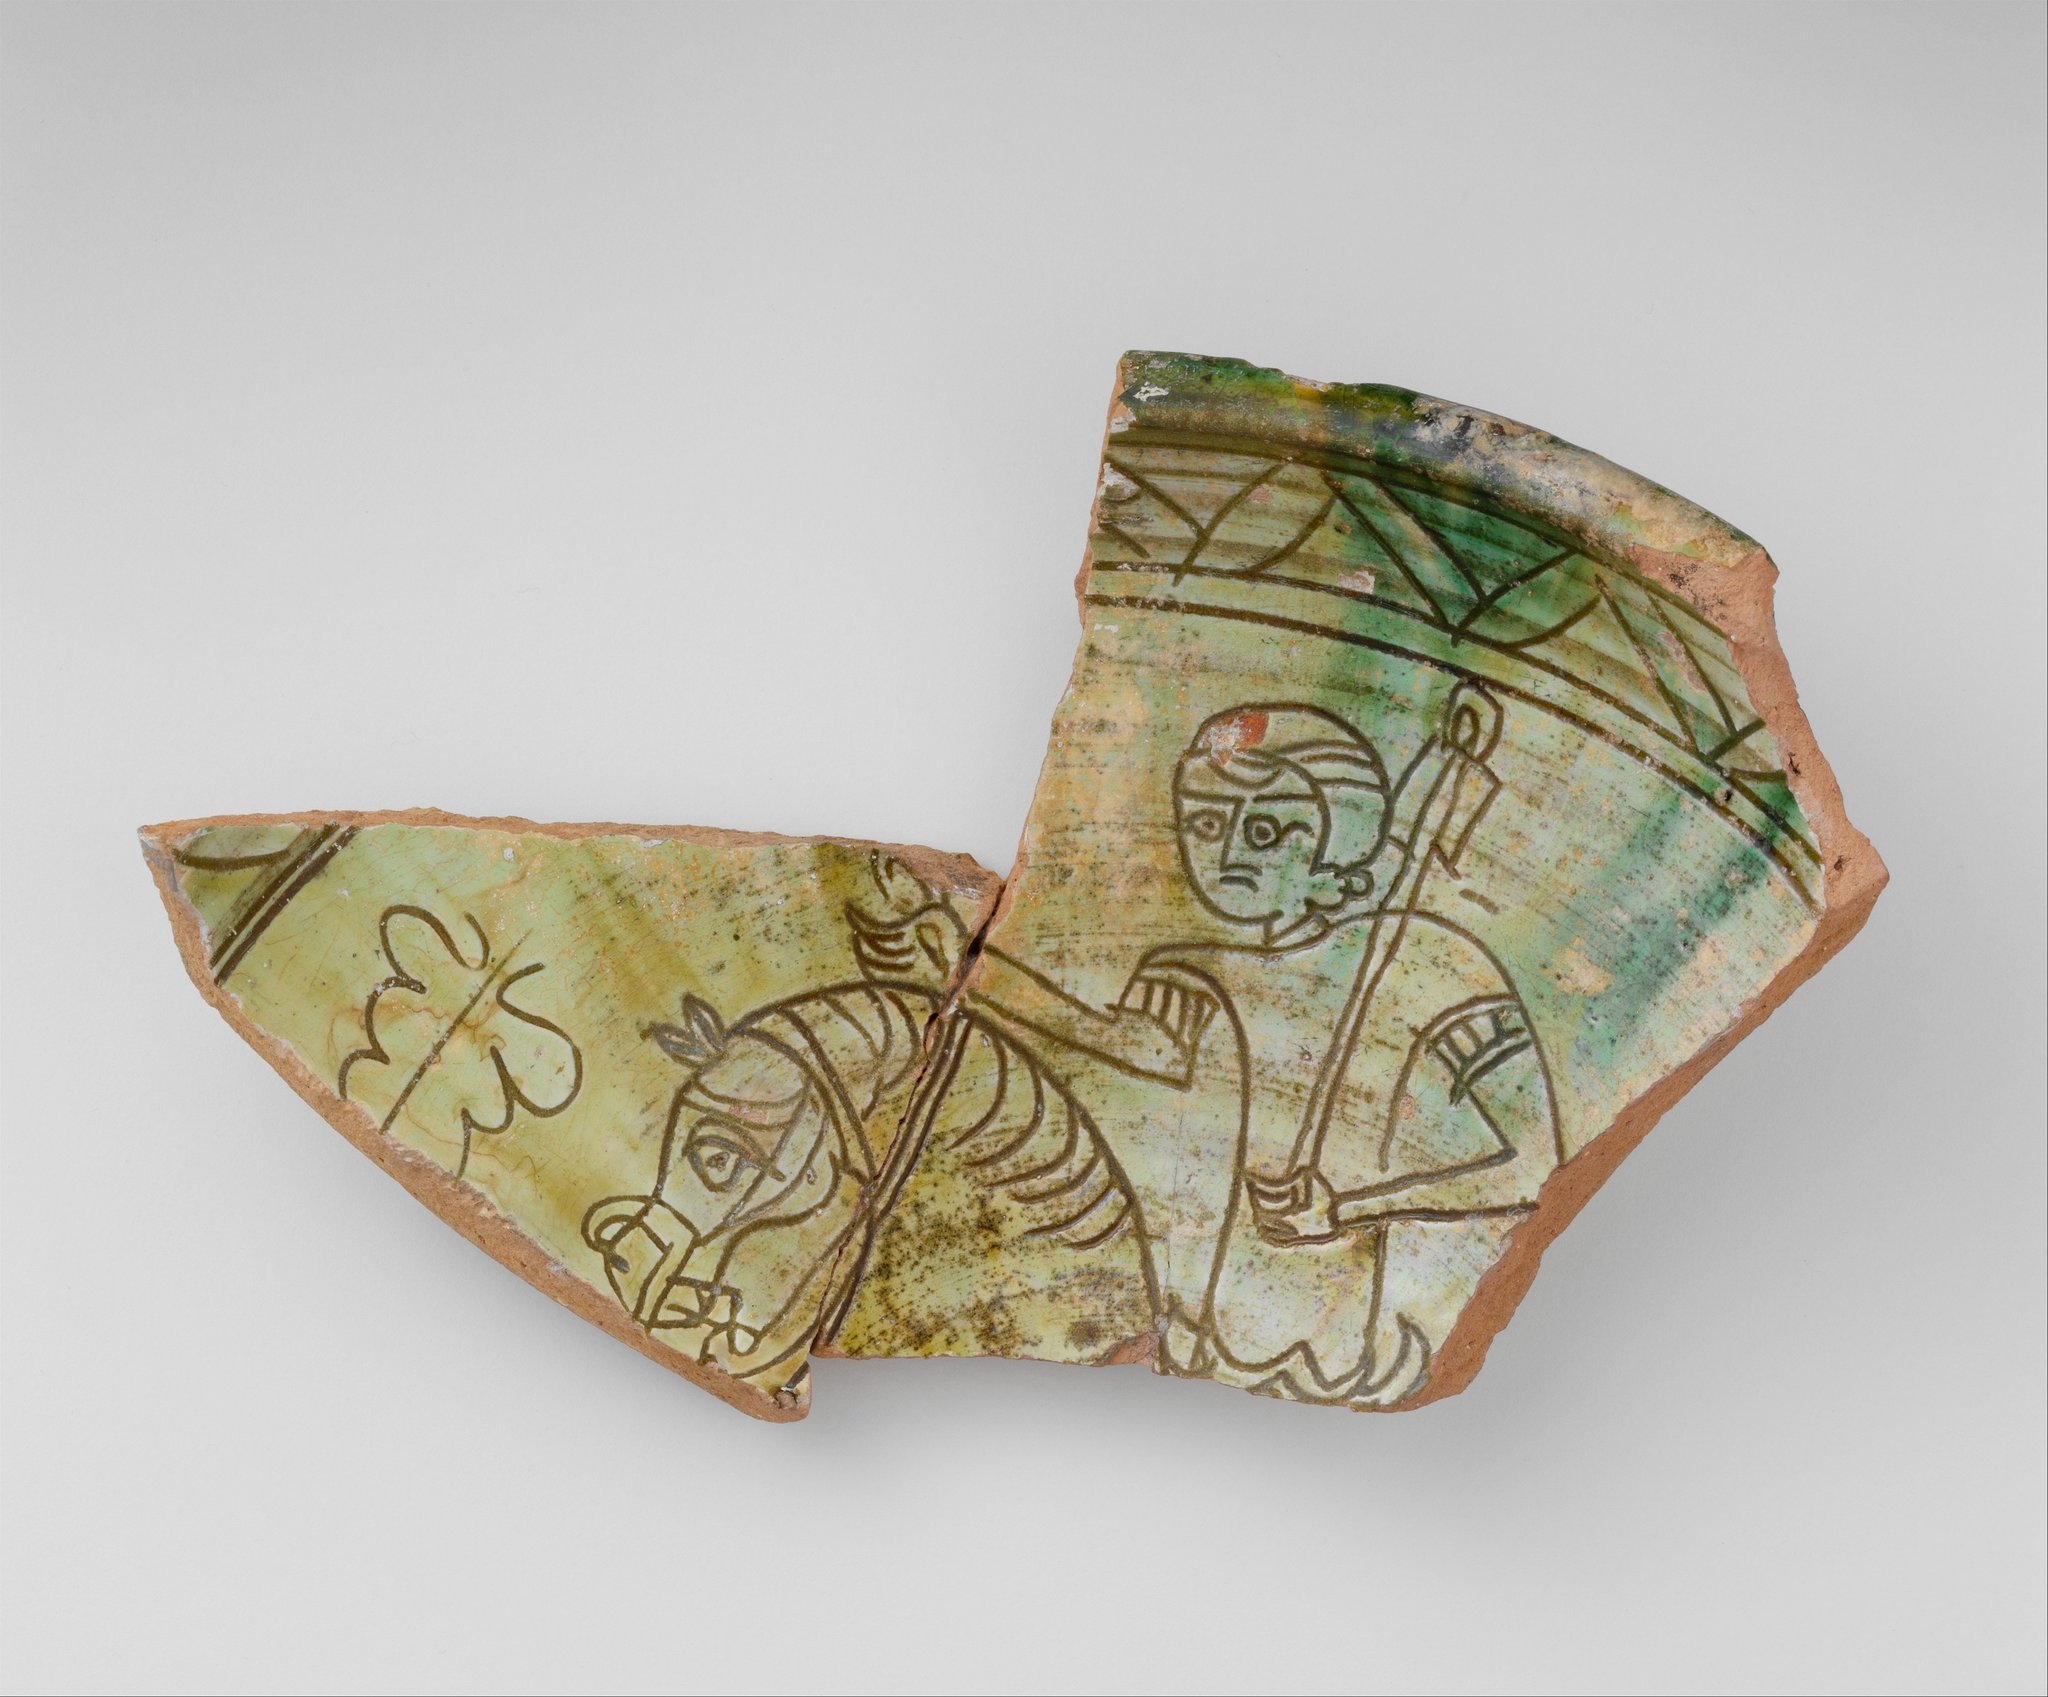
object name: fragment of a bowl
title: Fragment of a Bowl with a Horse and Rider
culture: byzantine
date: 1200-1268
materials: glaze, terracotta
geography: port saint symeon (now al-mina/samandag,turkey)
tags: men,horses